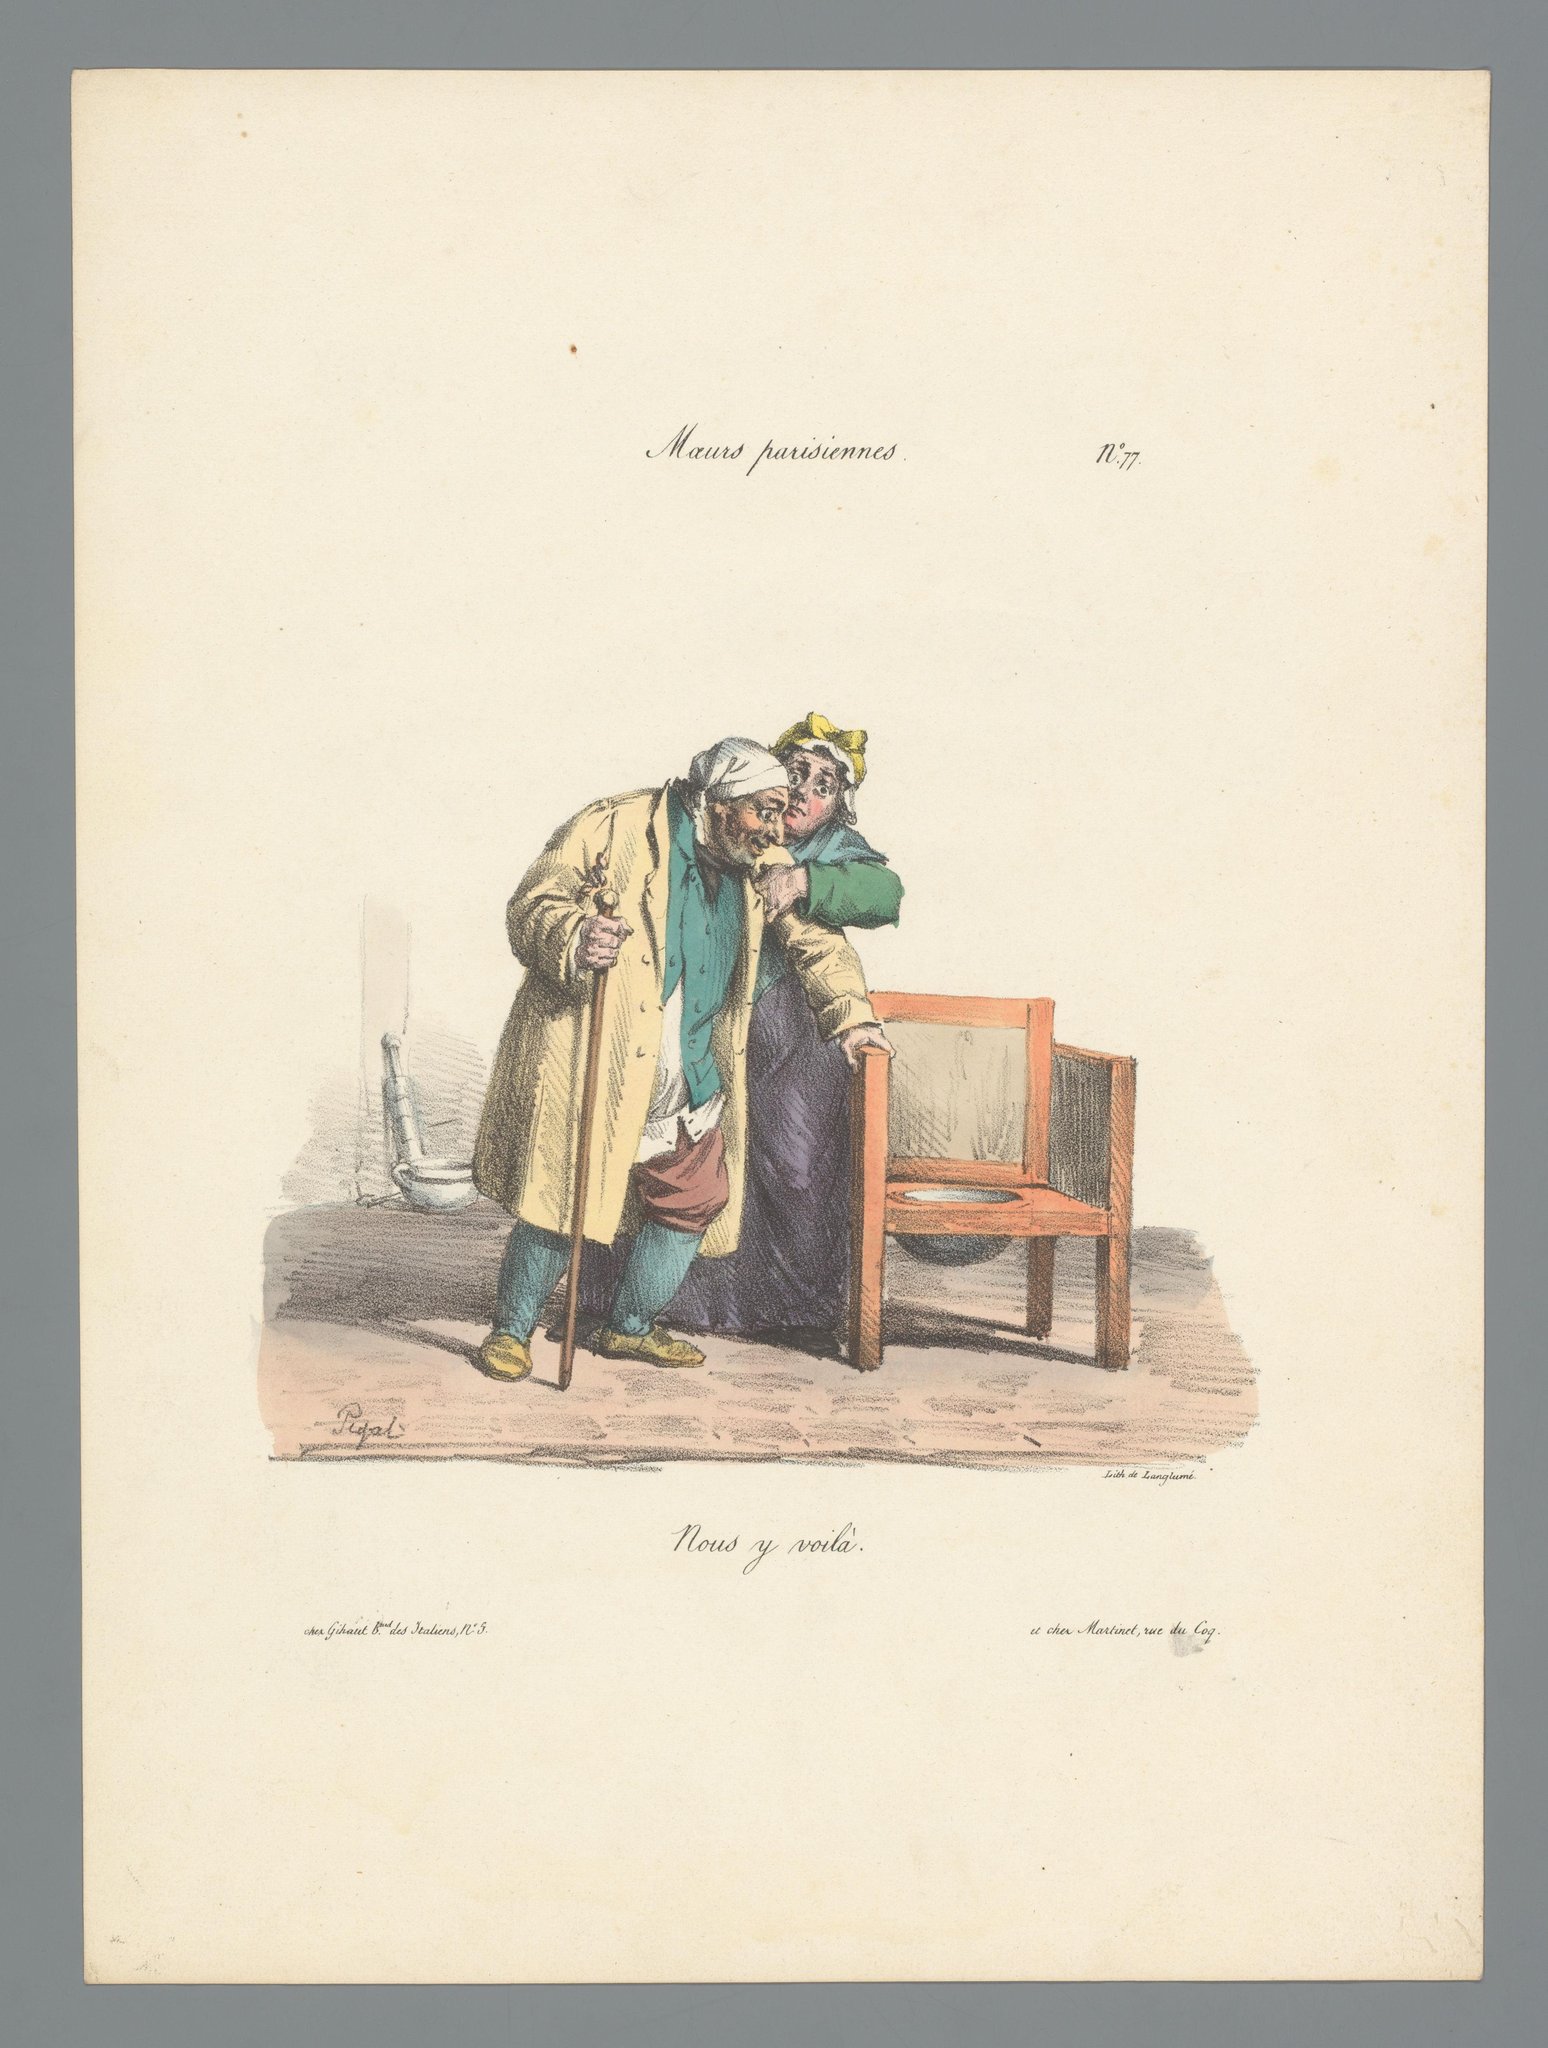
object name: print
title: Zeden en gewoonten van Parijs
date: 1824-1829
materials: paper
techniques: hand coloring, lithograph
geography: paris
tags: helpfulness, old man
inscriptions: collector's mark: Lugt 2228